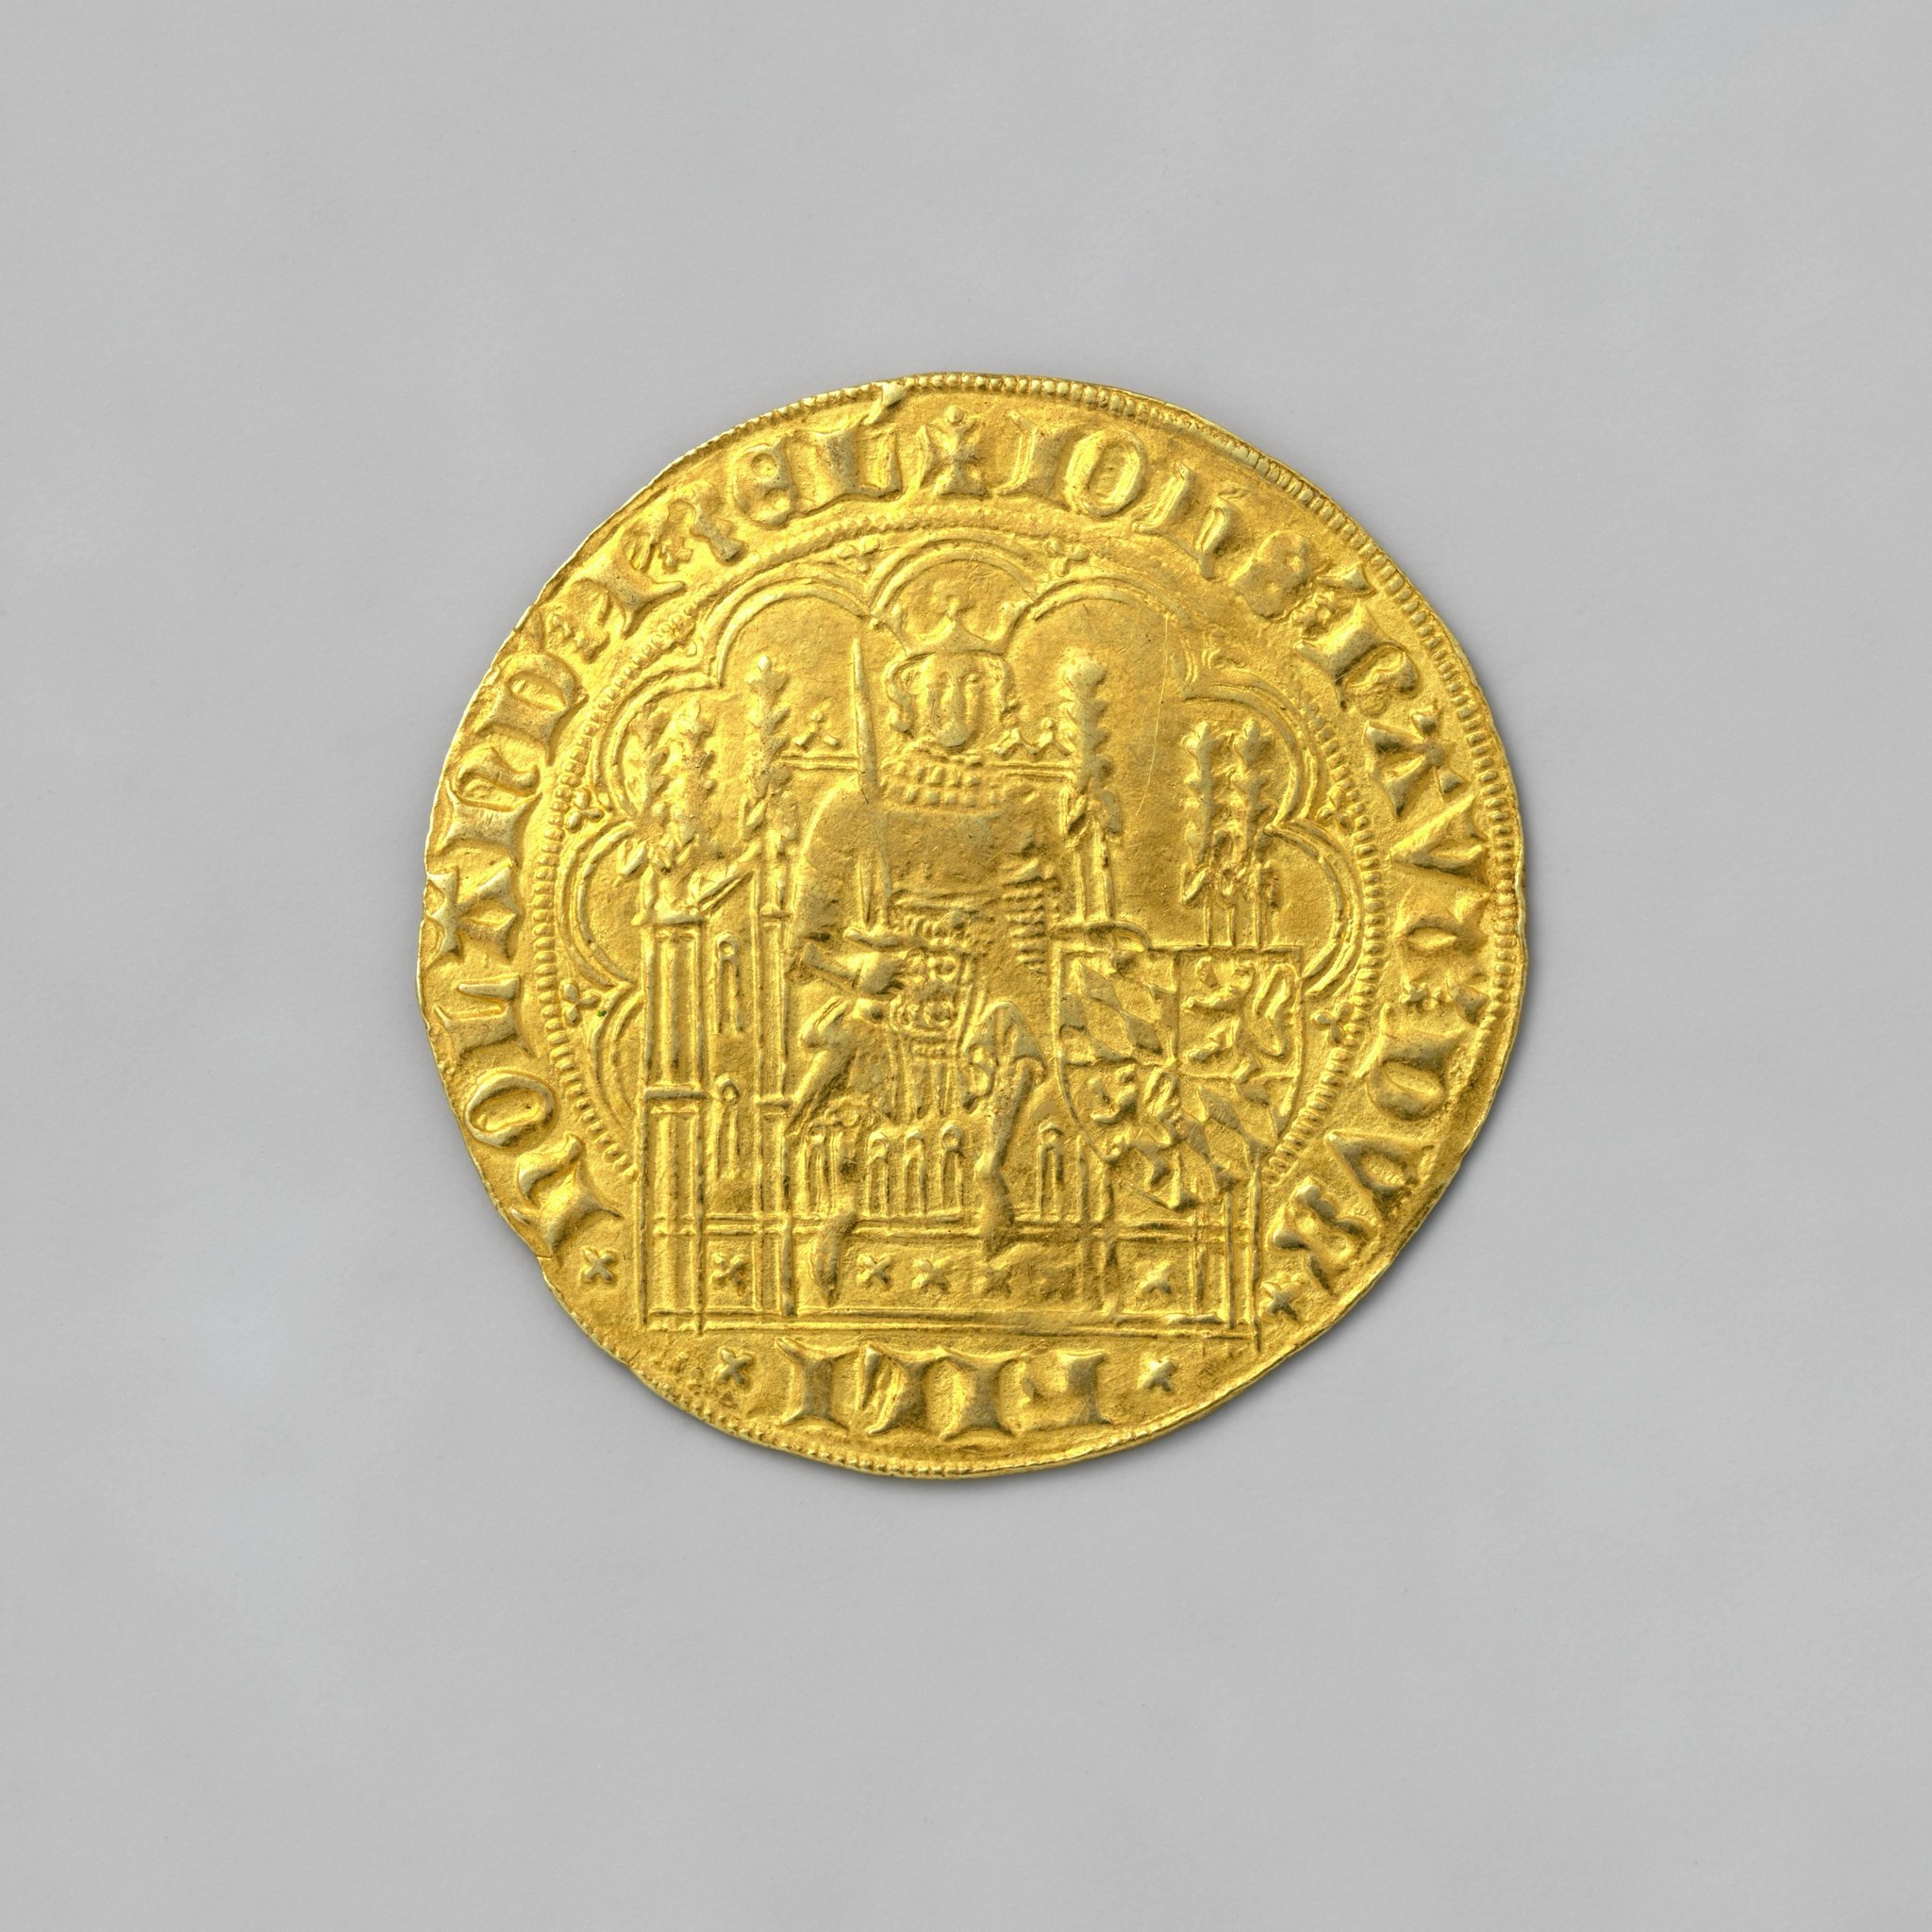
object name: gouden schild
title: Holland, Jan van Beieren, gouden schild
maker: jan van beieren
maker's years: 1374-1425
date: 1422-1425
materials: gold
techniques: striking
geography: dordrecht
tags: jan van beieren, holland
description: Voorzijde: in veelpas gekroonde graaf op troon, in rechterhand zwaard, linkerhand rustend op wapenschild van Beieren-Holland. Keerzijde: in vierpas kort versierd kruis.